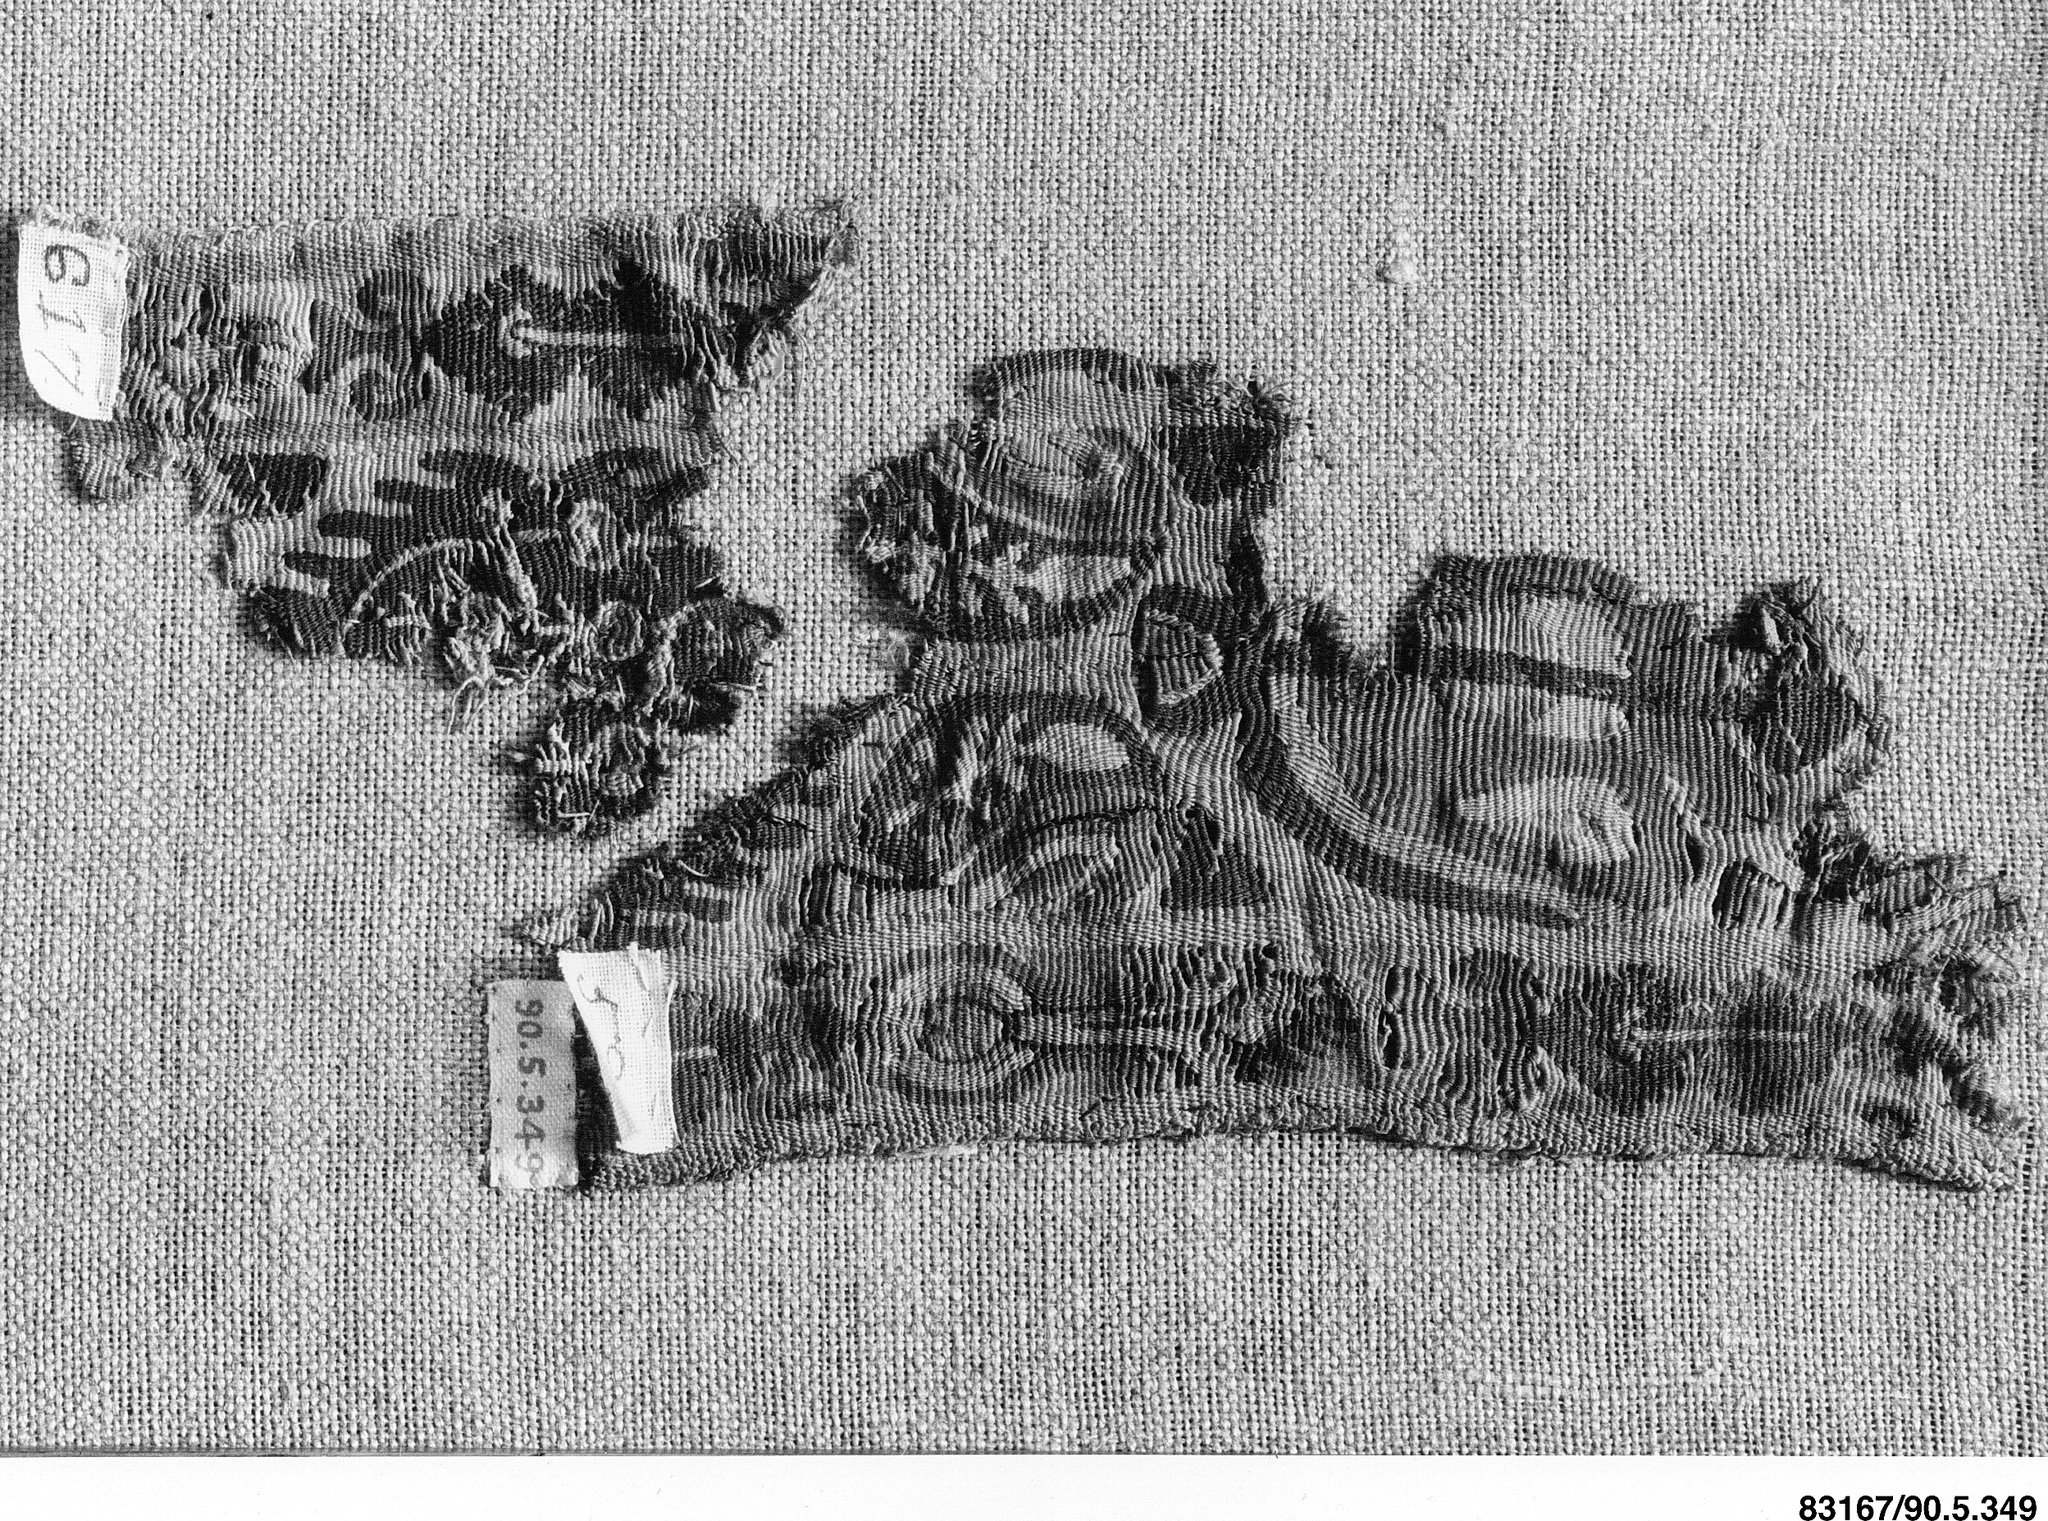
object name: textile fragment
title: Fragment of a Shoulder Band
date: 401-600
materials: linen, wool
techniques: weave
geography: egypt